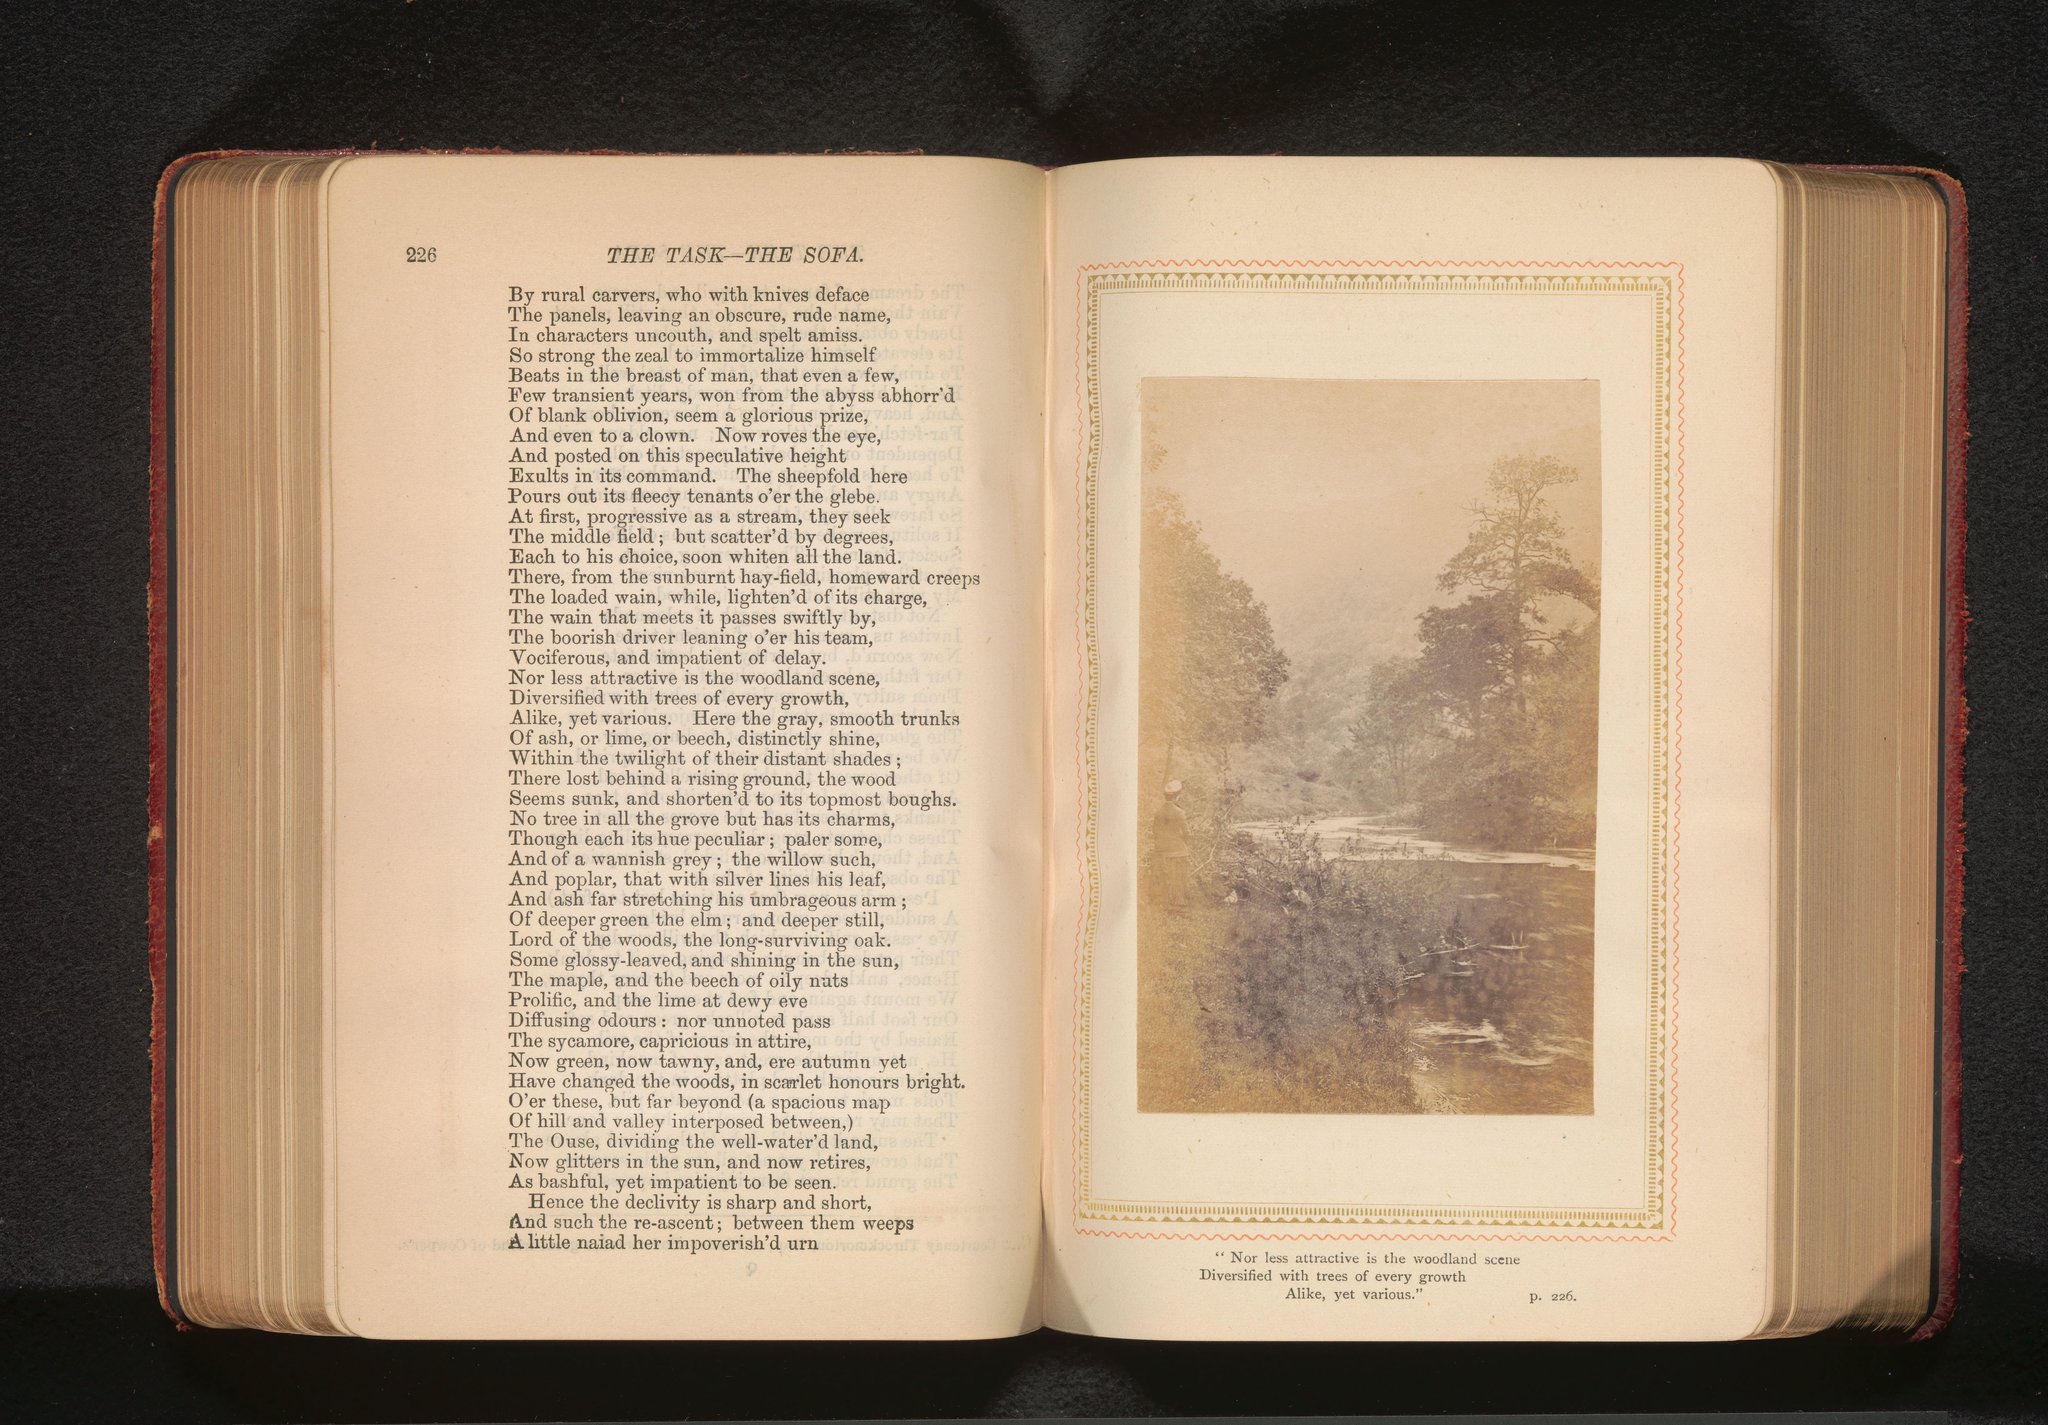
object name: page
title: Gezicht op een rivier, met op de oever een vrouw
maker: Anonymous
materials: photographic support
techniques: albumen print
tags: water course (+ landscape with figures, staffage)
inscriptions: inscription: ‘"Nor less attractive is the woodland scene/ Diversified with trees of every growth/ Alike, yet various."/ p. 226.’